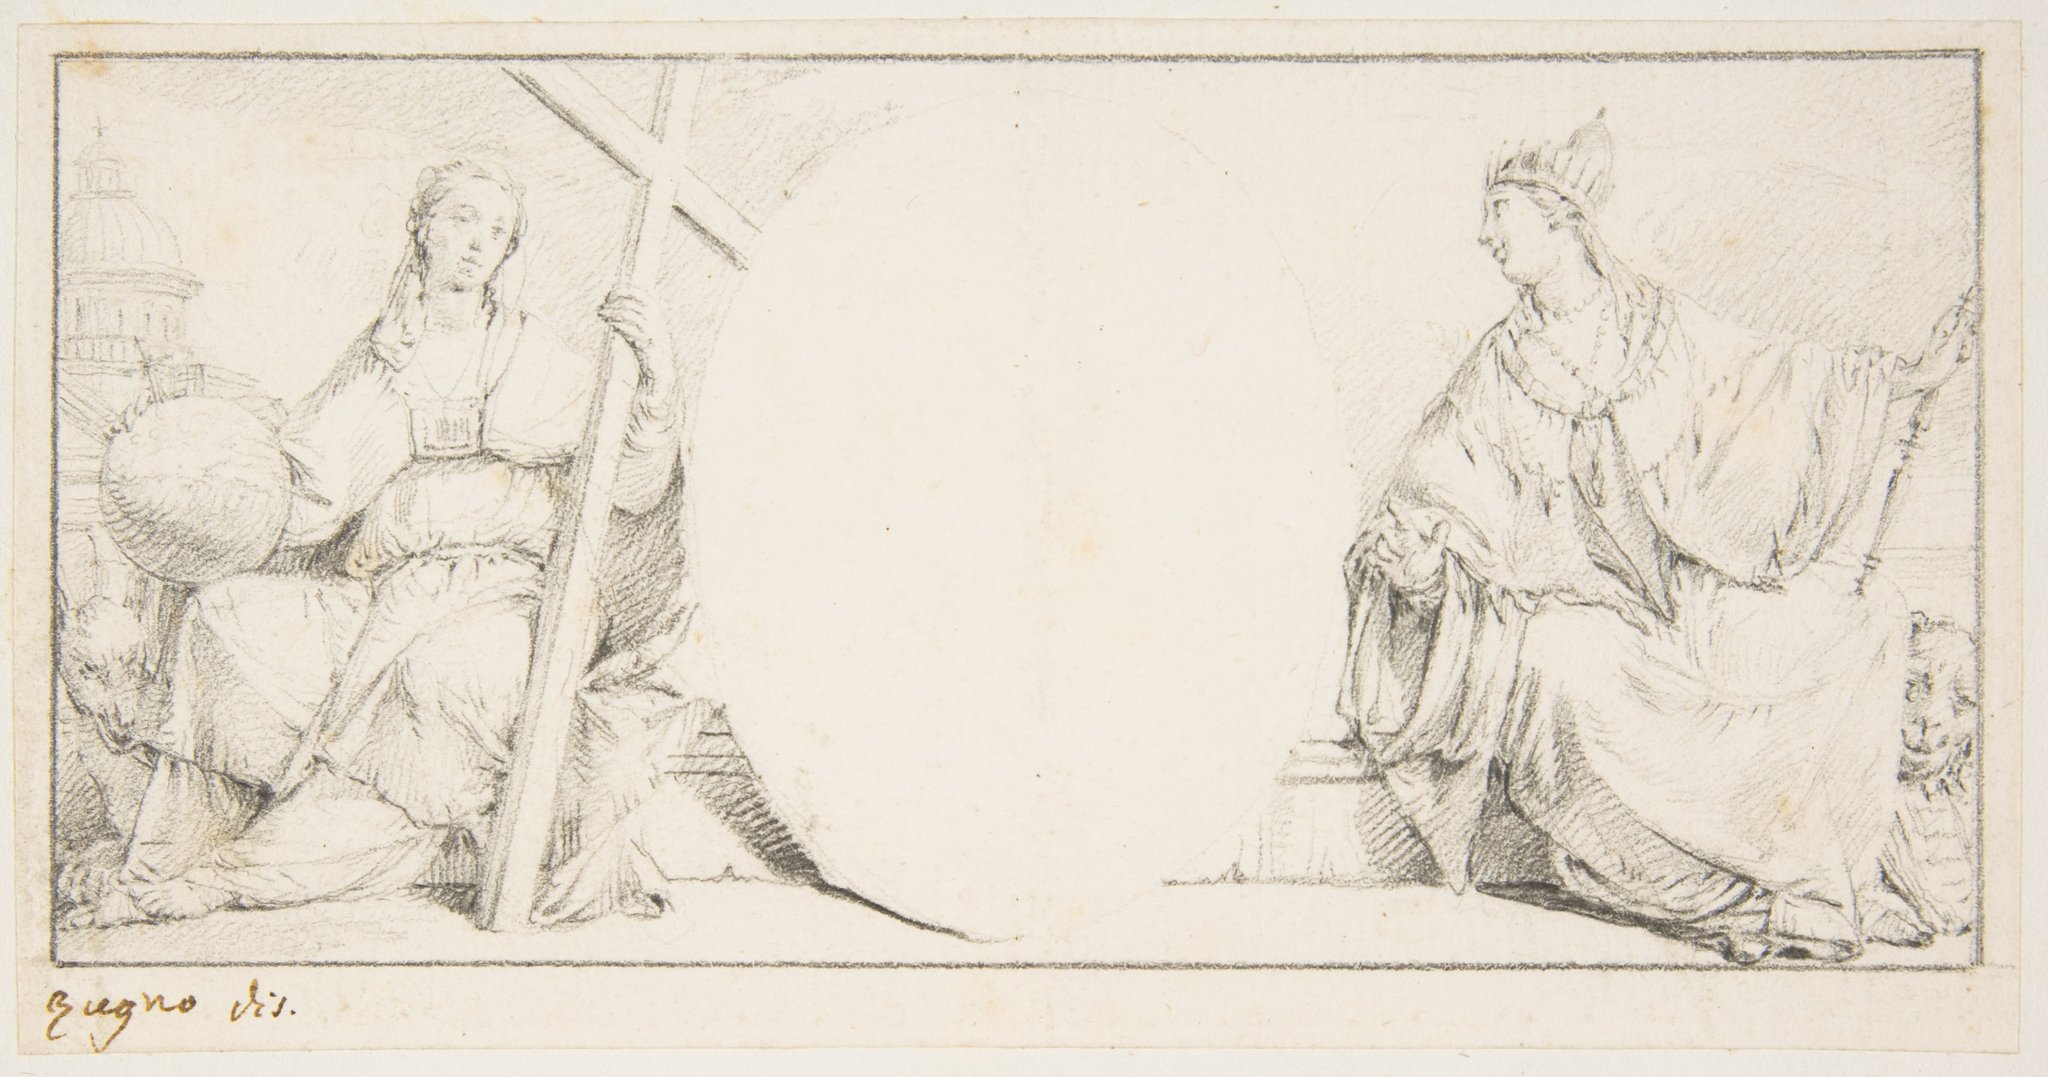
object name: drawing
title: Allegorical Figures of Religion and Venice Flanking an Empty Cartouche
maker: francesco zugno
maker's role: artist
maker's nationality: italian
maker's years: 1709-1787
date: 1709-1787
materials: graphite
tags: cartouches,women,cross